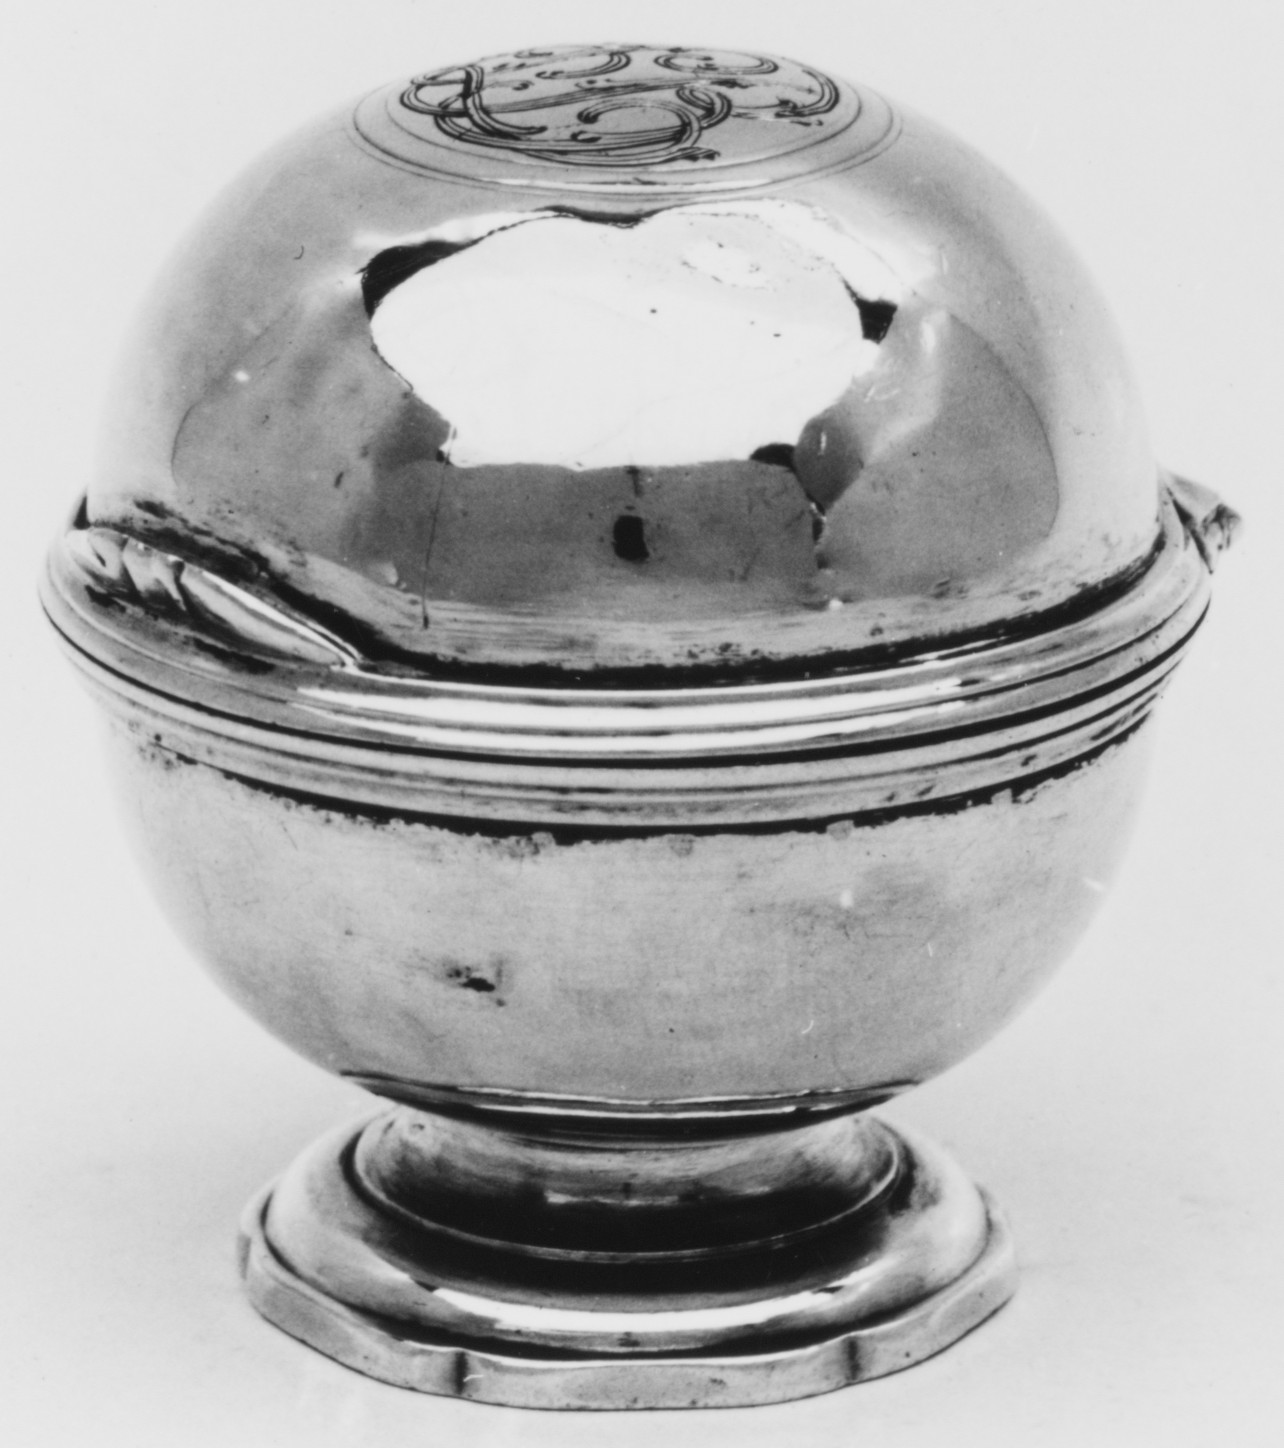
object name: toilet box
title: Miniature toilet box (one of a pair)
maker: pierre françois rigal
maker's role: maker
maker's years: 1721-1789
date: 1772-1774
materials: silver